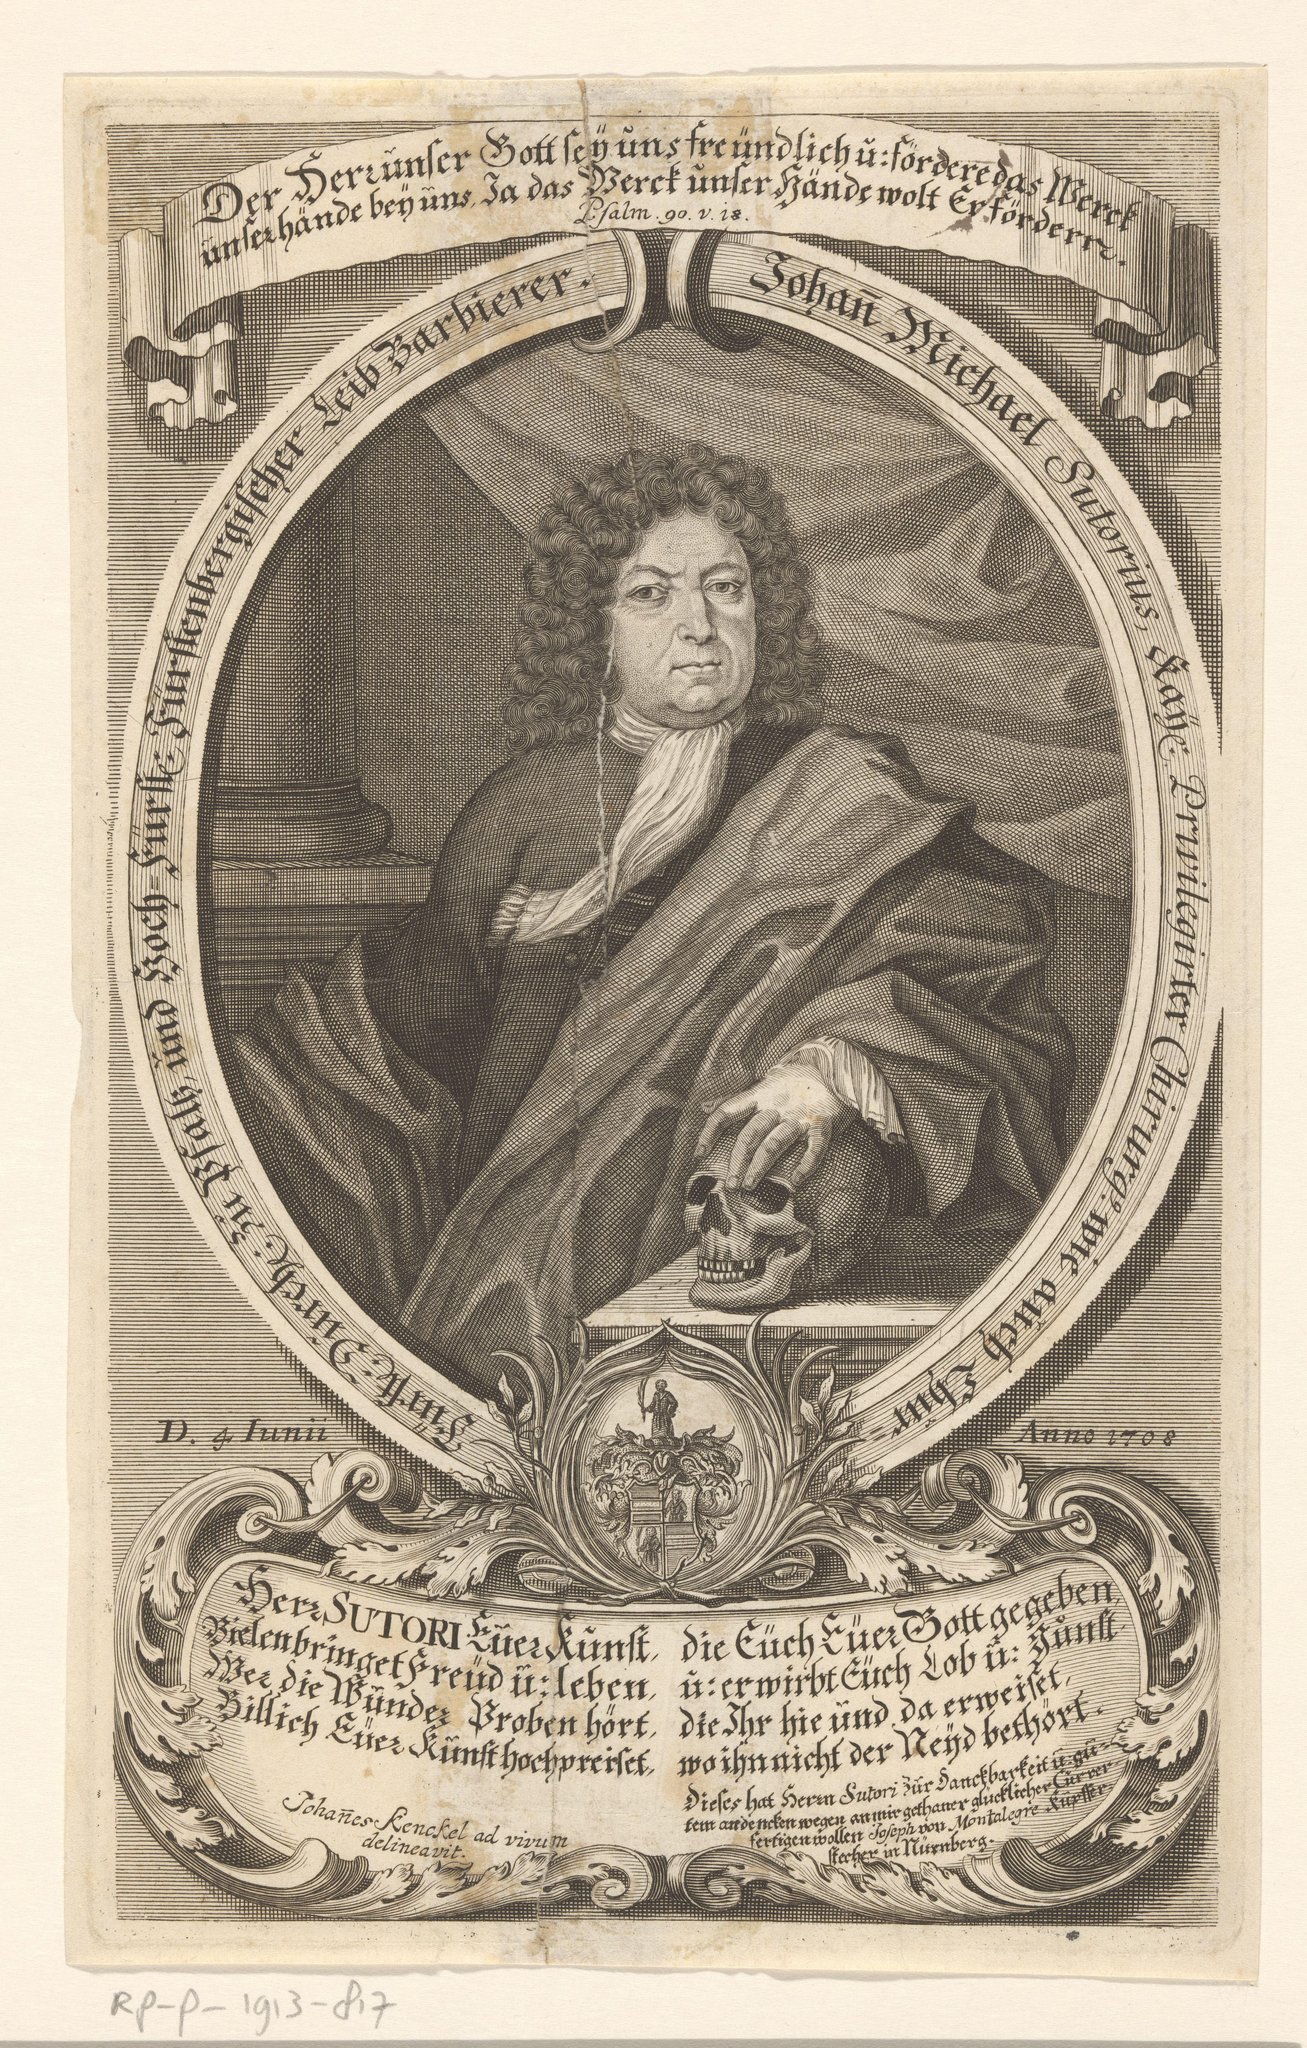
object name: print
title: Portret van Johann Michael Sutorius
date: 1708-1799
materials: paper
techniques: engraving, etching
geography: nuremberg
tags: historical persons, wig, meditation over skull and/or crucifix, armorial bearing, heraldry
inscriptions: collector's mark: Lugt 2228